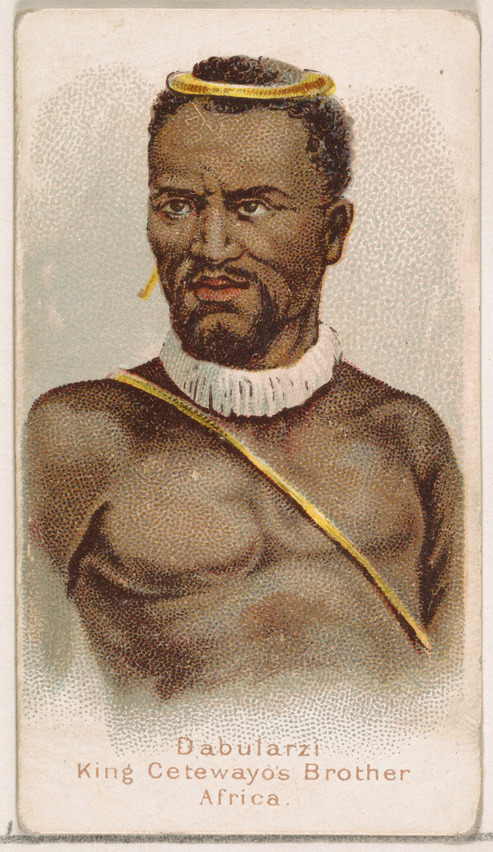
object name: print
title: Dabularzi, King Cetewayo's Brother, Africa, from the Savage and Semi-Barbarous Chiefs and Rulers series (N189) issued by Wm. S. Kimball & Co.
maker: william s. kimball & company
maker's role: publisher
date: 1888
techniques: color lithograph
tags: men,portraits